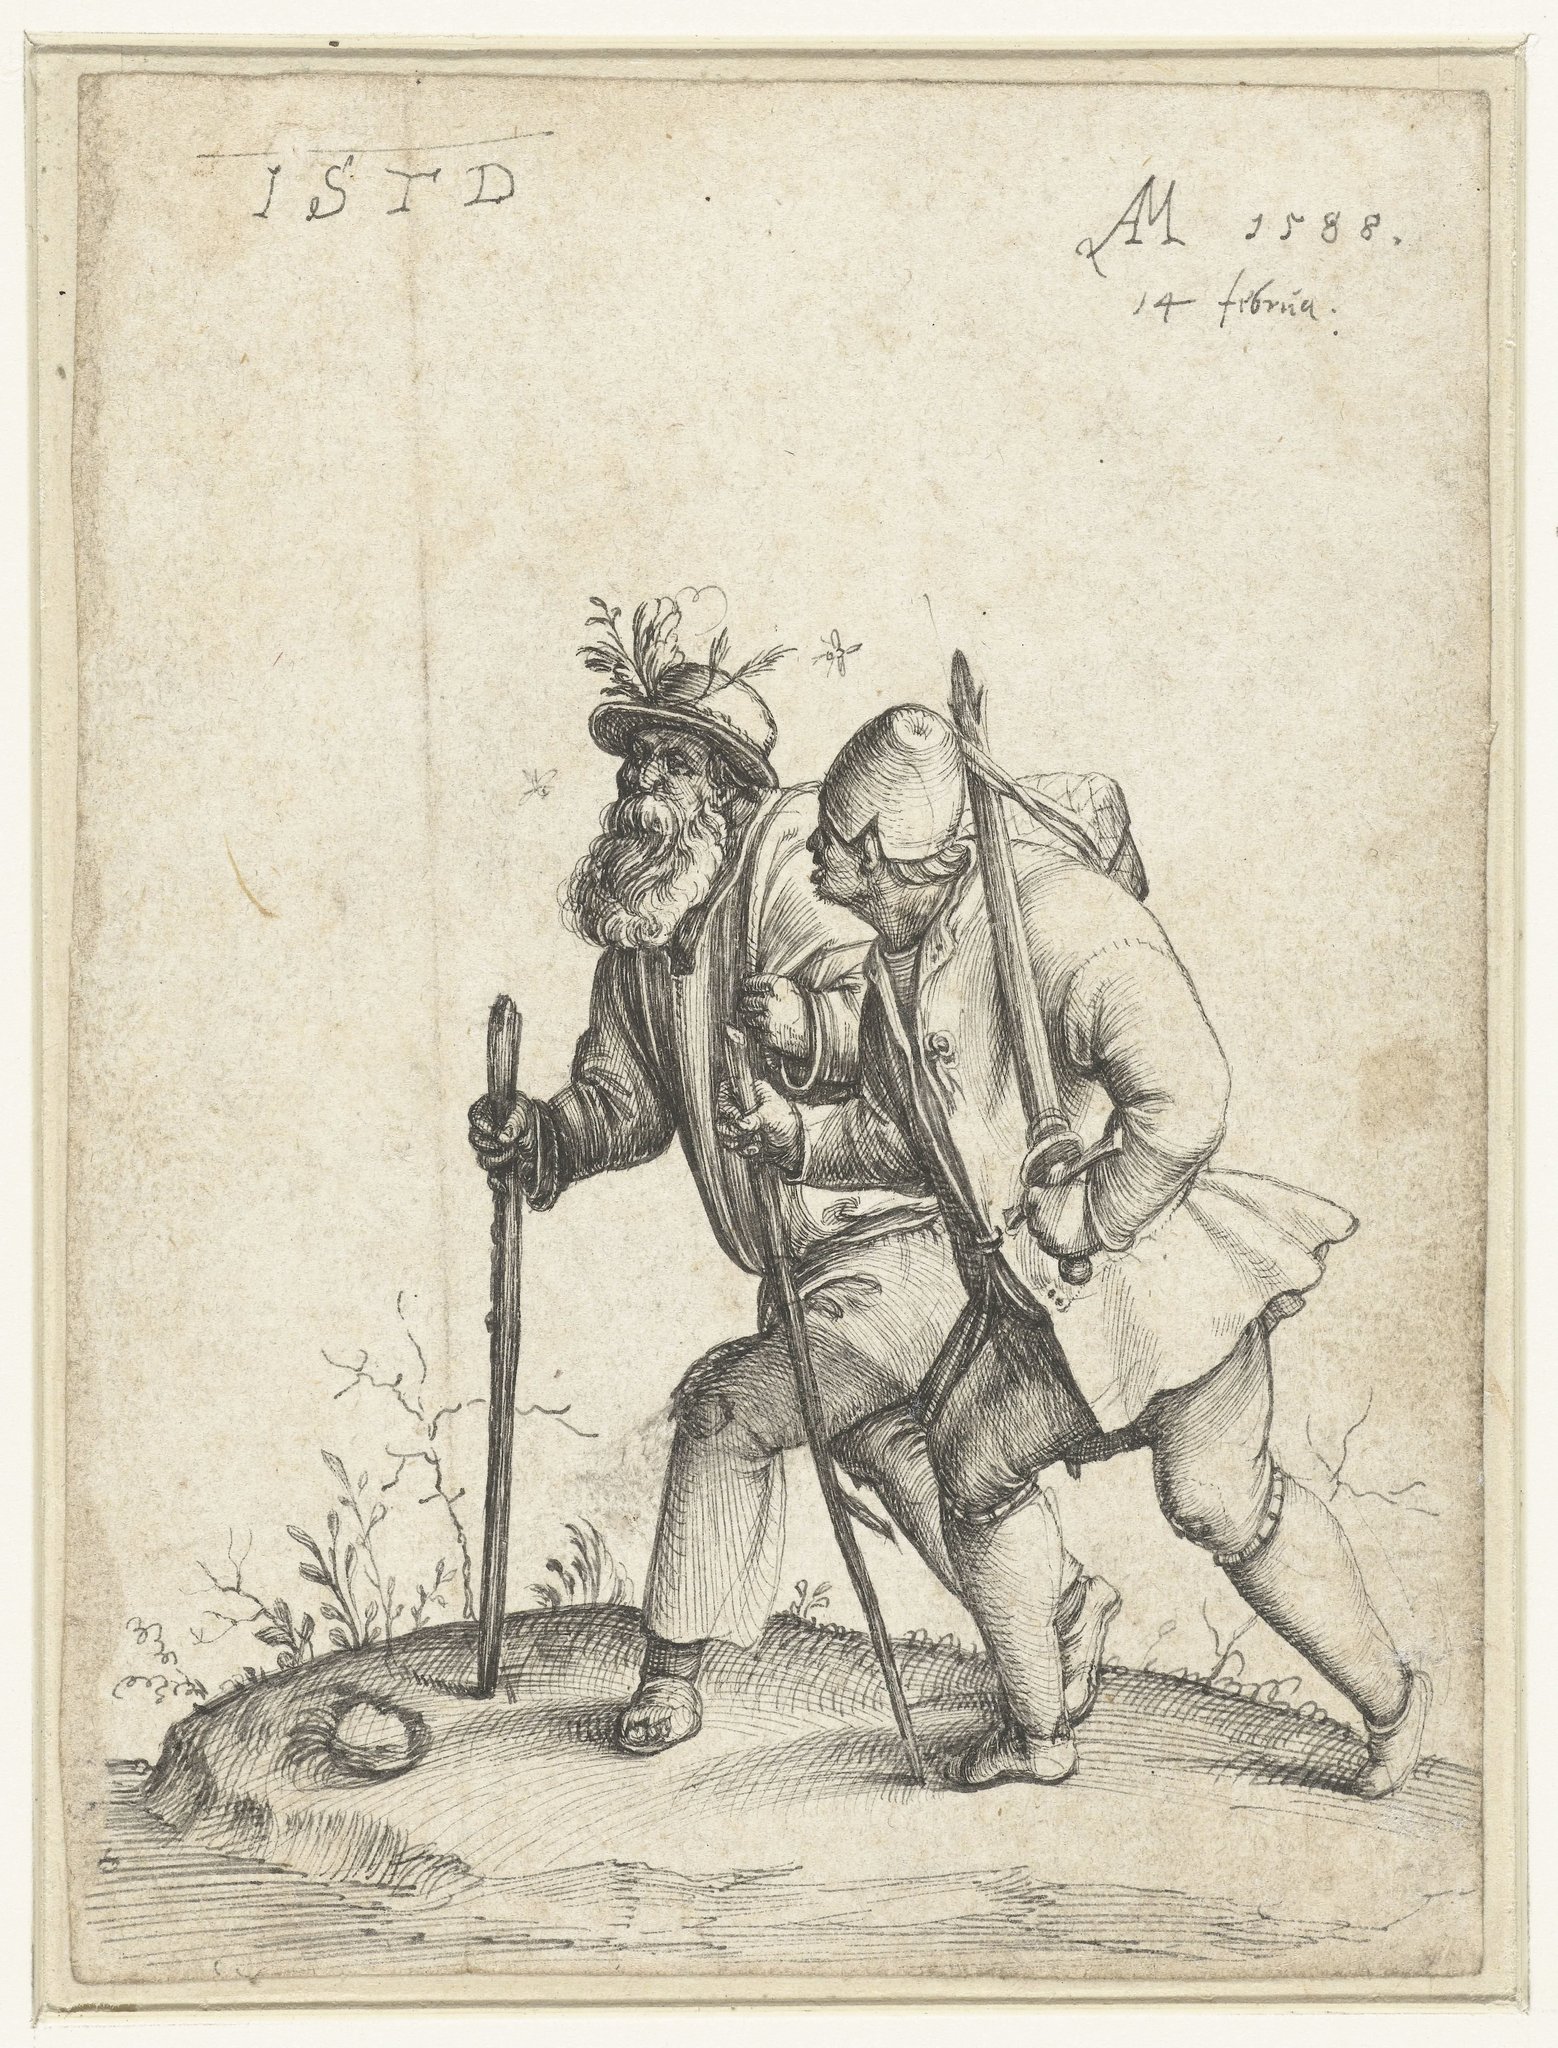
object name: drawing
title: Oude zwerver met jongeman met zwaard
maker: anton möller (der ältere)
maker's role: draughtsman, print maker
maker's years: 1563-1611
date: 1588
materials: ink, paper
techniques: pen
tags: 'fahrende leute', vagrants, 'en route', traveller under way